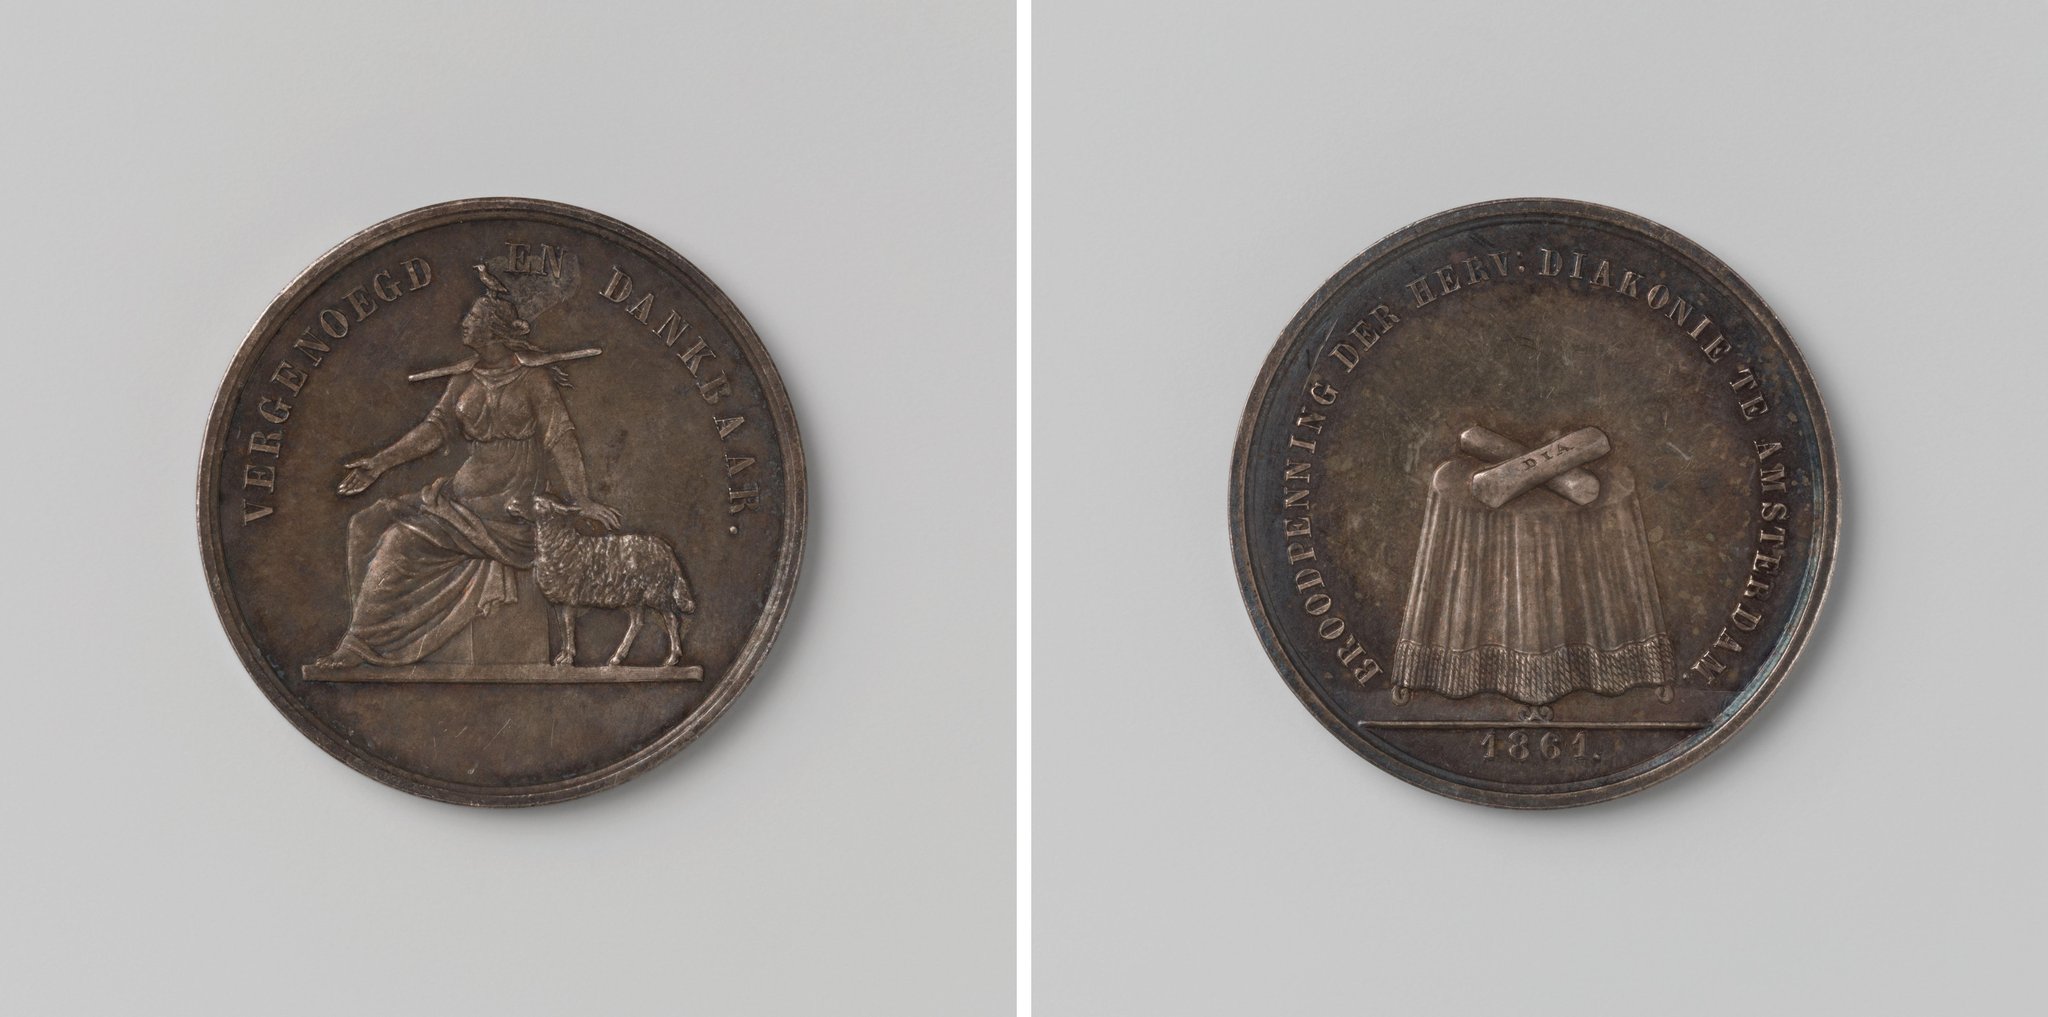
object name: medal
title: Hervormde Diakonie te Amsterdam, penning in de vorm van een armenpenning, geschonken aan nieuw aangekomen diakenen en diakenessen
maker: david van der kellen (1804-1879)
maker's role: die cutter, draughtsman, print maker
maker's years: 1804-1879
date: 1861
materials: silver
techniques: striking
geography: amsterdam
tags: amsterdam